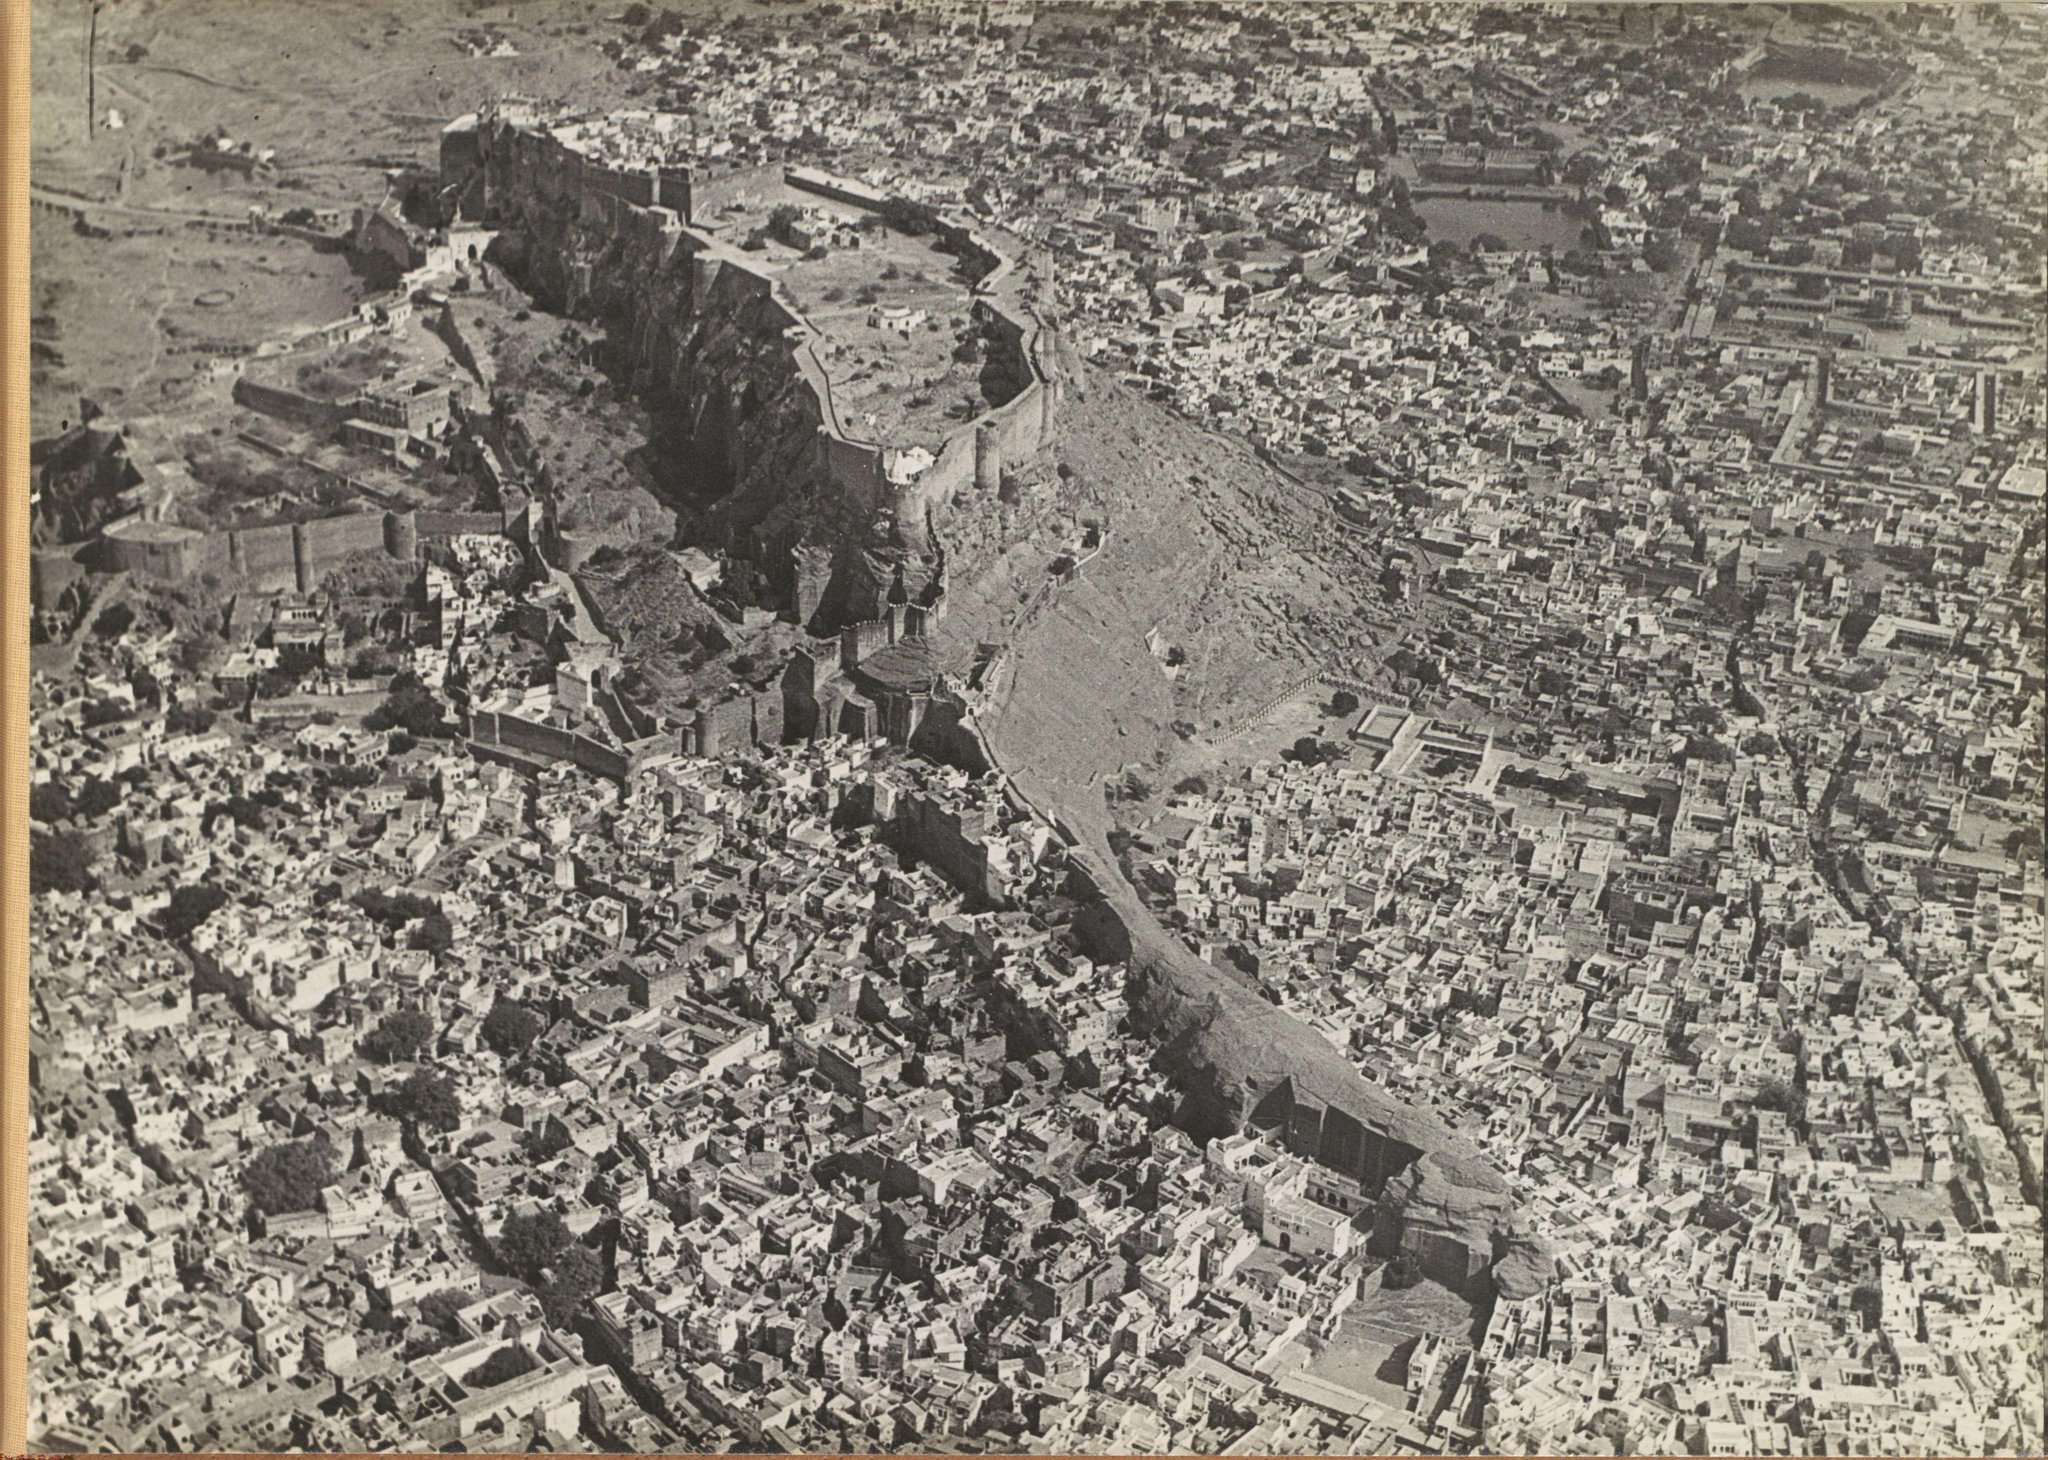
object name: album leaf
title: Stad met een fort, gezien vanuit de lucht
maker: Anonymous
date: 1930-1940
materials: cardboard, paper, photographic support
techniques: gelatin silver print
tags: fortress, airborne traffic, aviation, travelling; tourism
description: Albumblad met een foto van een stad met een ommuurd fort op een berg. Waarschijnlijk is het in de buurt van één van de plaatsen waar een tussenstop werd gemaakt op de KLM-vlucht Amsterdam-Batavia. Onderdeel van Herdenkingsalbum van de Indië-lijn van de KLM, deel I.